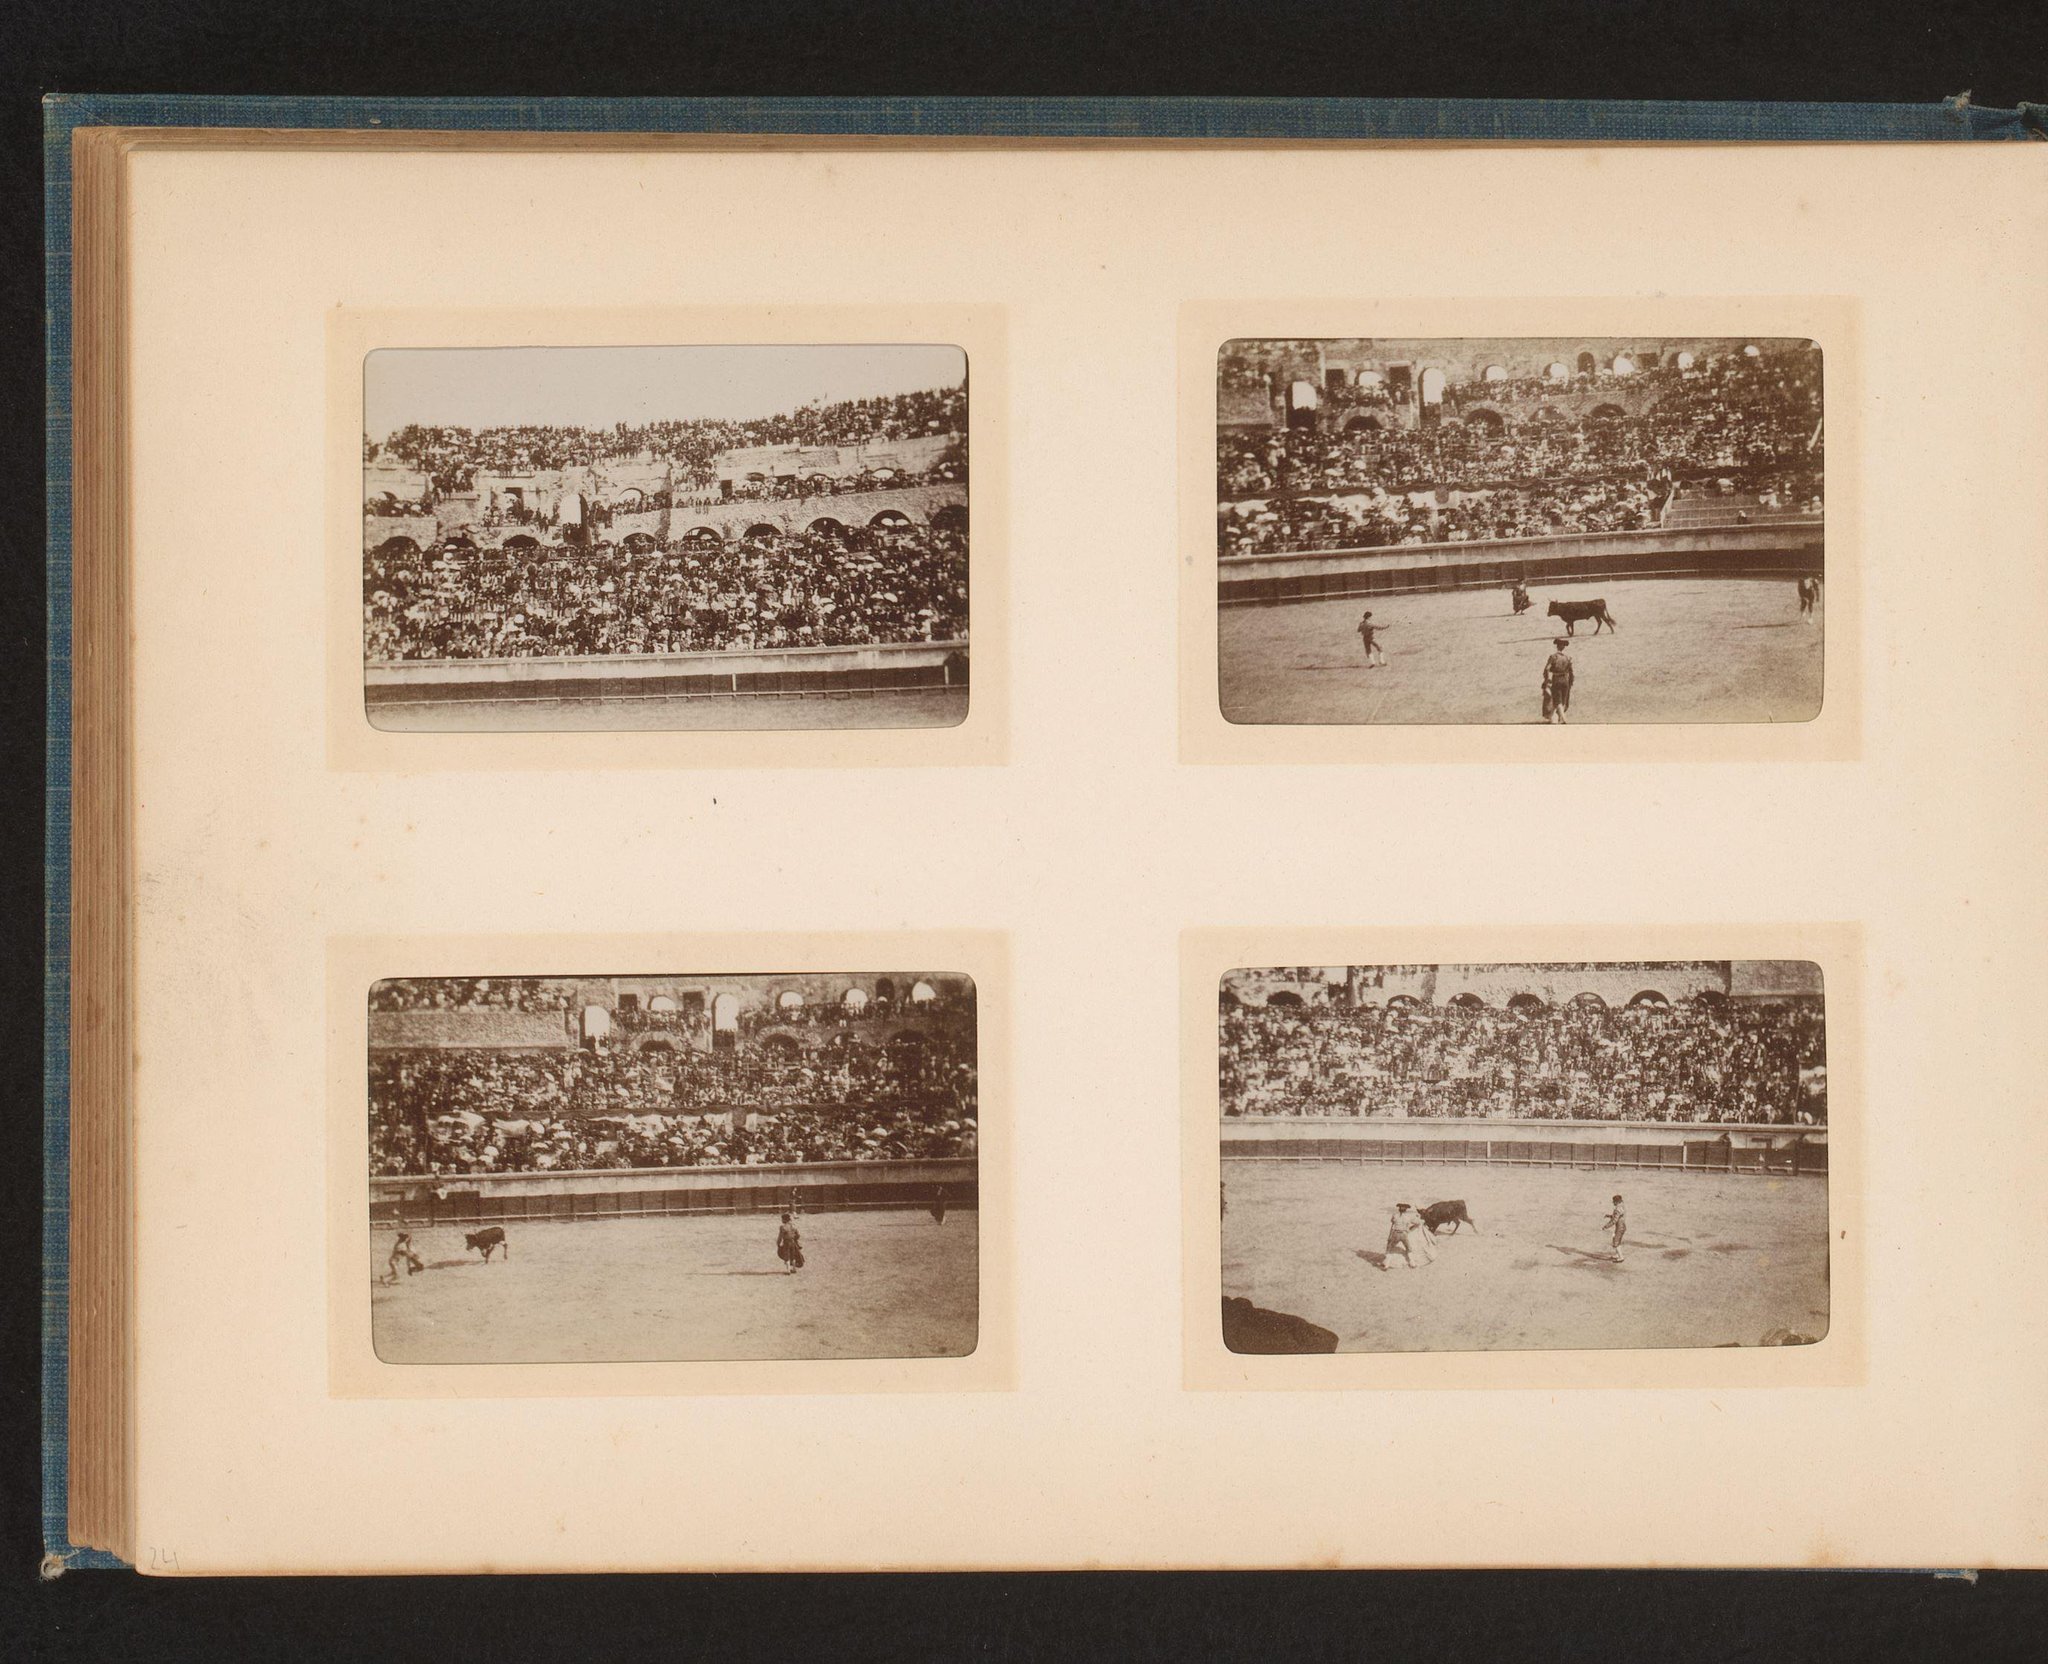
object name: photograph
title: Drie opnamen van stierengevechten in het amfitheater te Arles en Publiek tijdens het stierenvechten in het amfitheater te Arles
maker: Anonymous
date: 1900-1915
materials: paper, photographic support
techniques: gelatin silver print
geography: france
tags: bullfight, amphitheatre, travelling; tourism, the audience ~ art performance, france